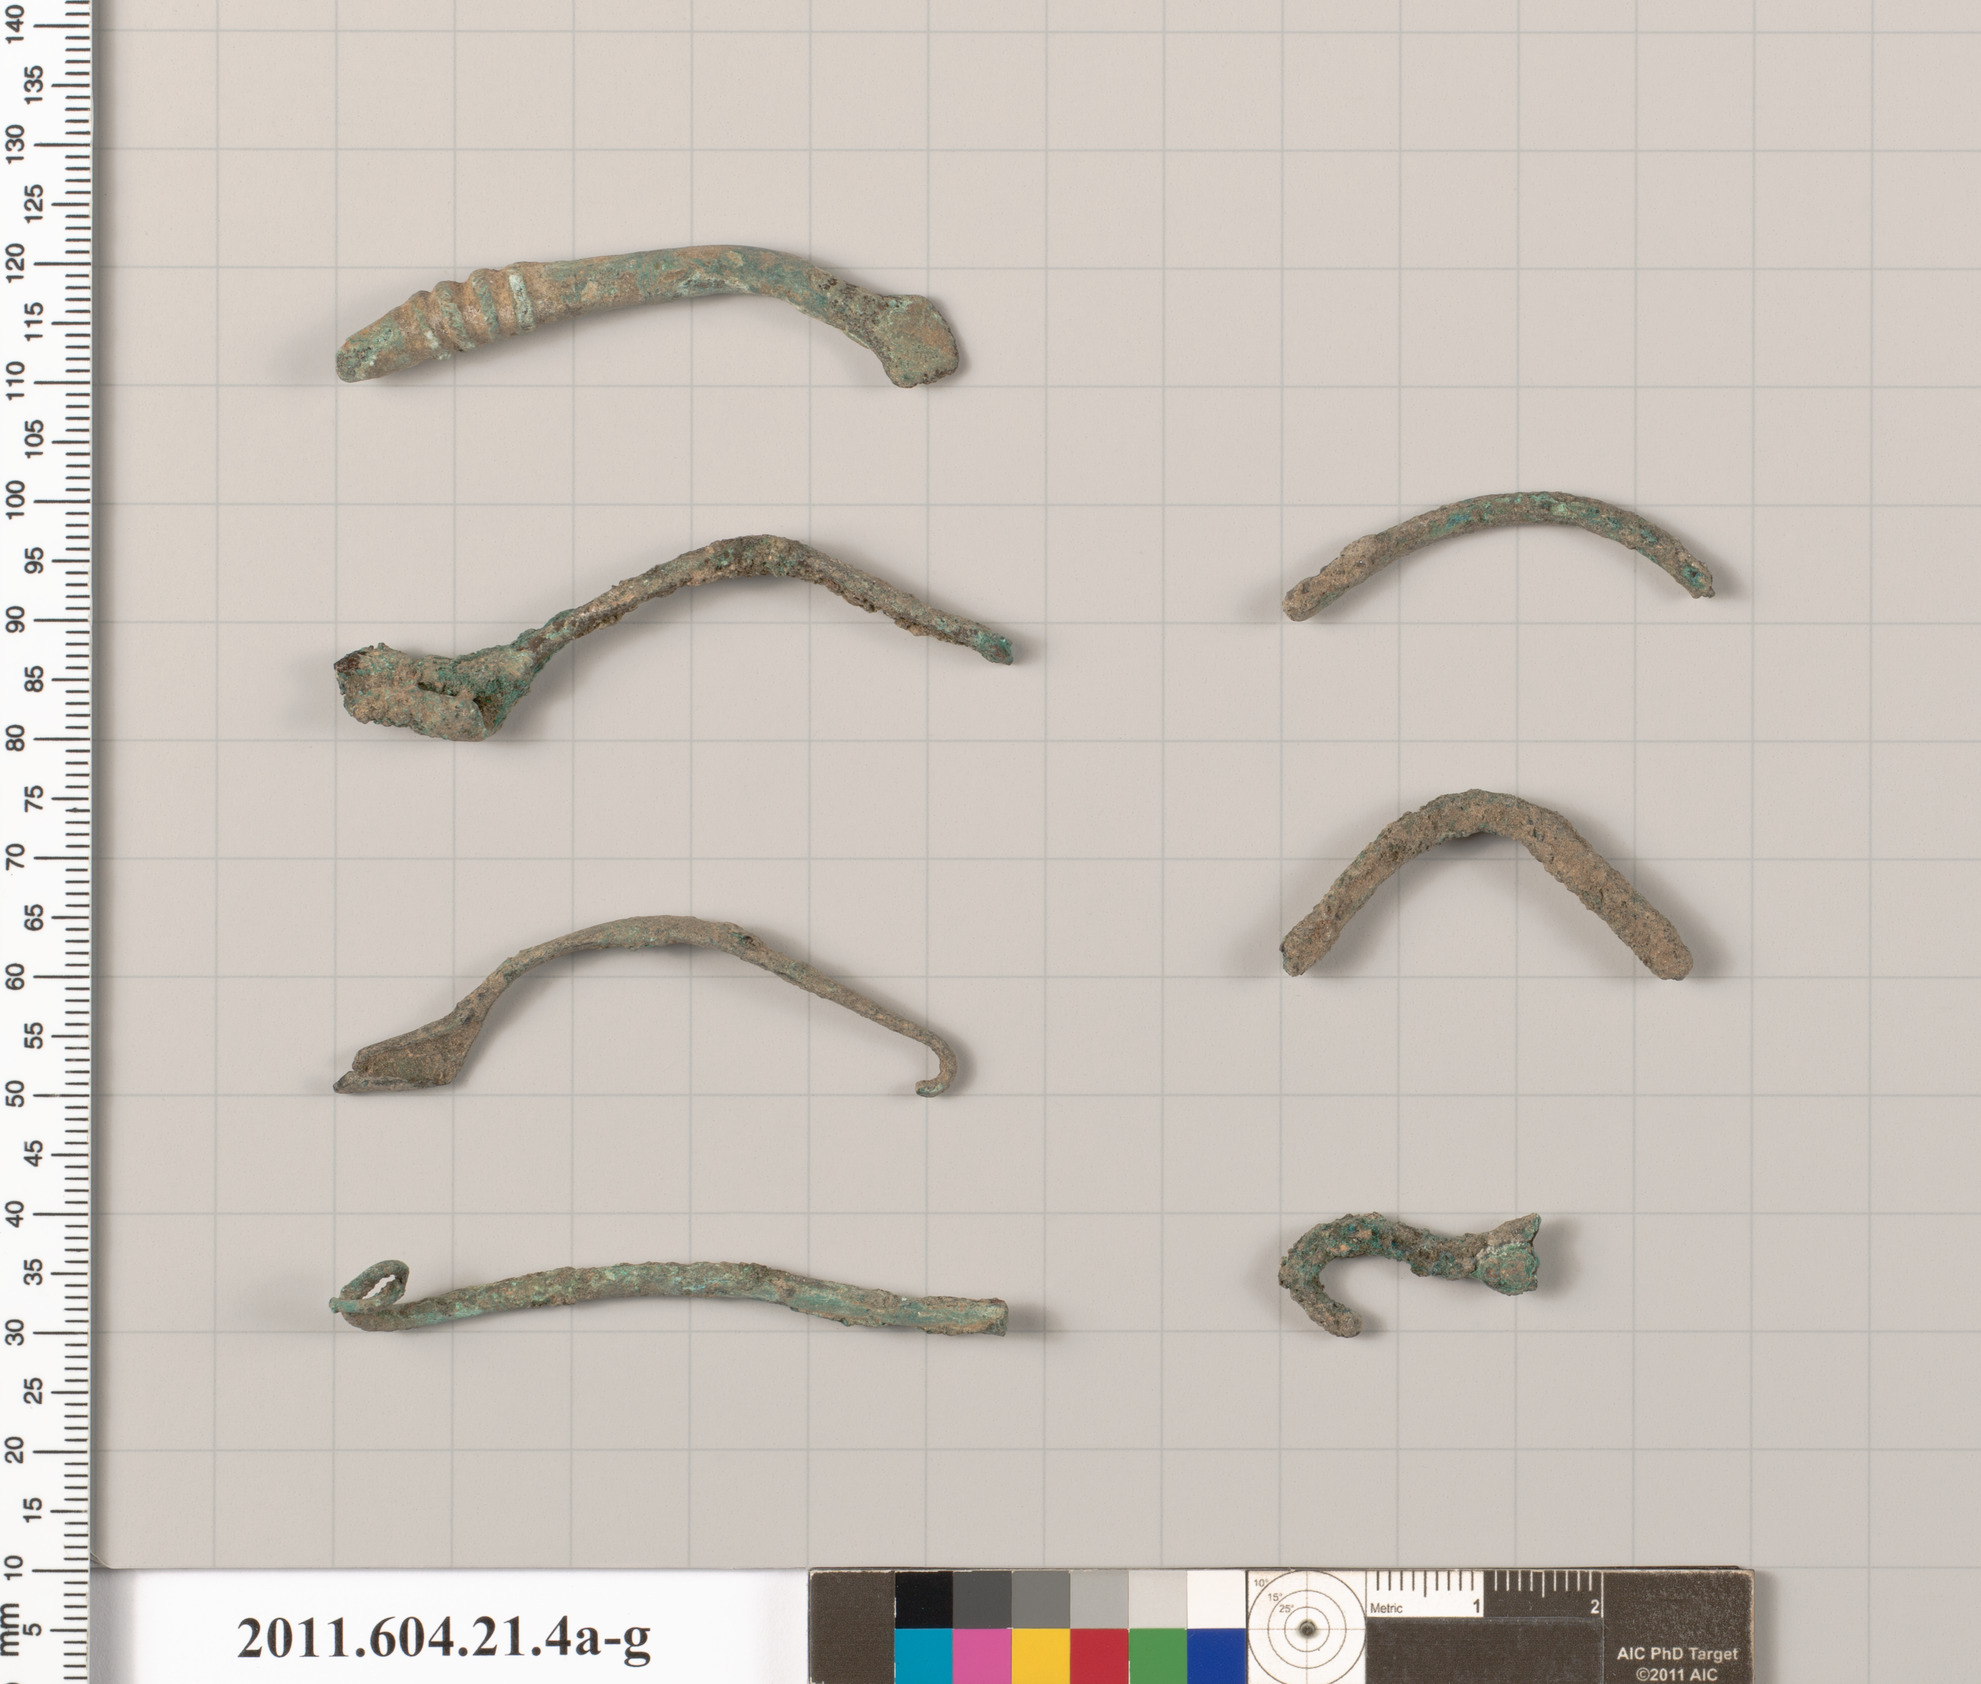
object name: fibula, fragment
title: Fragments of fibulae (safety pins)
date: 700-501 BCE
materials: bronze